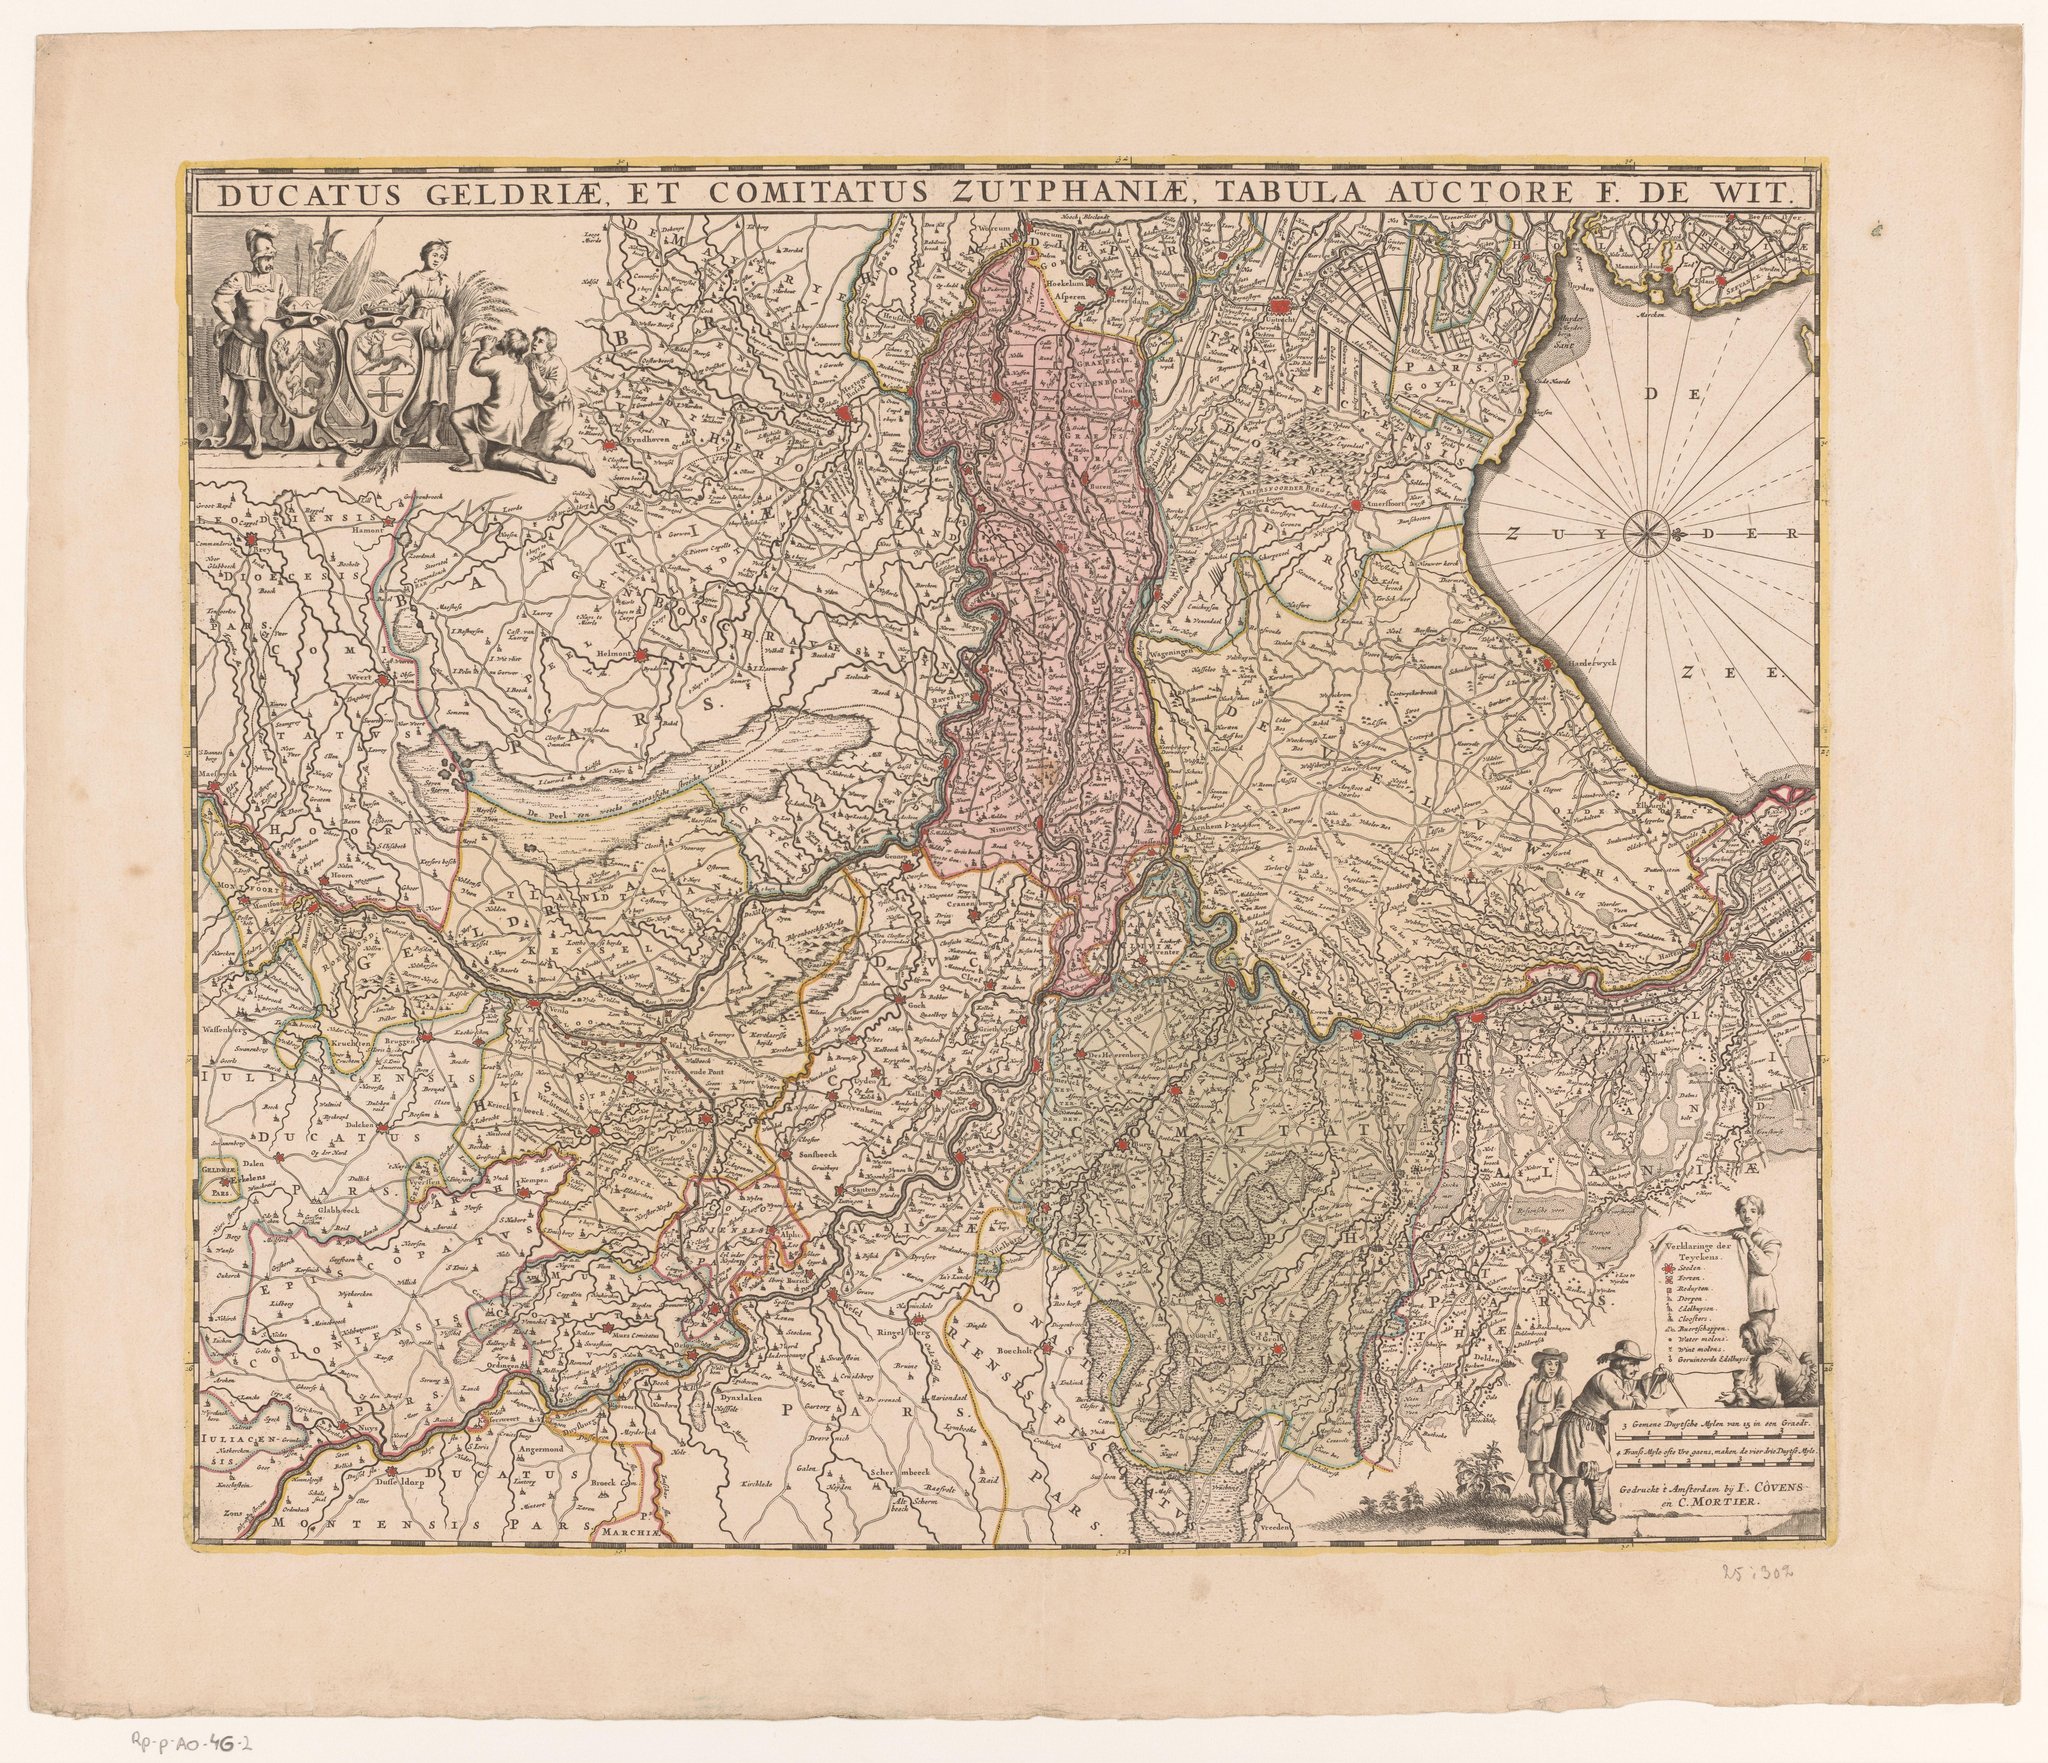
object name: map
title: Ducatus Geldriae, et comitatus Zutphaniae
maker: abraham jansz. deur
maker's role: print maker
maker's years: 1640-1719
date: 1721-1774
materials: paper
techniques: engraving, etching, hand coloring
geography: amsterdam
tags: coat of arms (as symbol of the state, etc.) (+ city; municipal), maps of separate countries or regions, coat of arms (as symbol of the state, etc.) (+ province; provincial), gelderland, guelders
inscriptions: collector's mark: Lugt 2228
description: De titel in een balk boven de kaart. Linksboven de wapens van Gelre en de stad Zutphen. Rechtsonder een legenda en een cartouche met twee schaalstokken: 3 Gemene Duytsche Mylen van 15 in een Graedt / 4 Franse Myle ofte Ure gaens, maken de vier drie Duytse Myle. De kaart is voorzien van een gradenverdeling langs de randen.